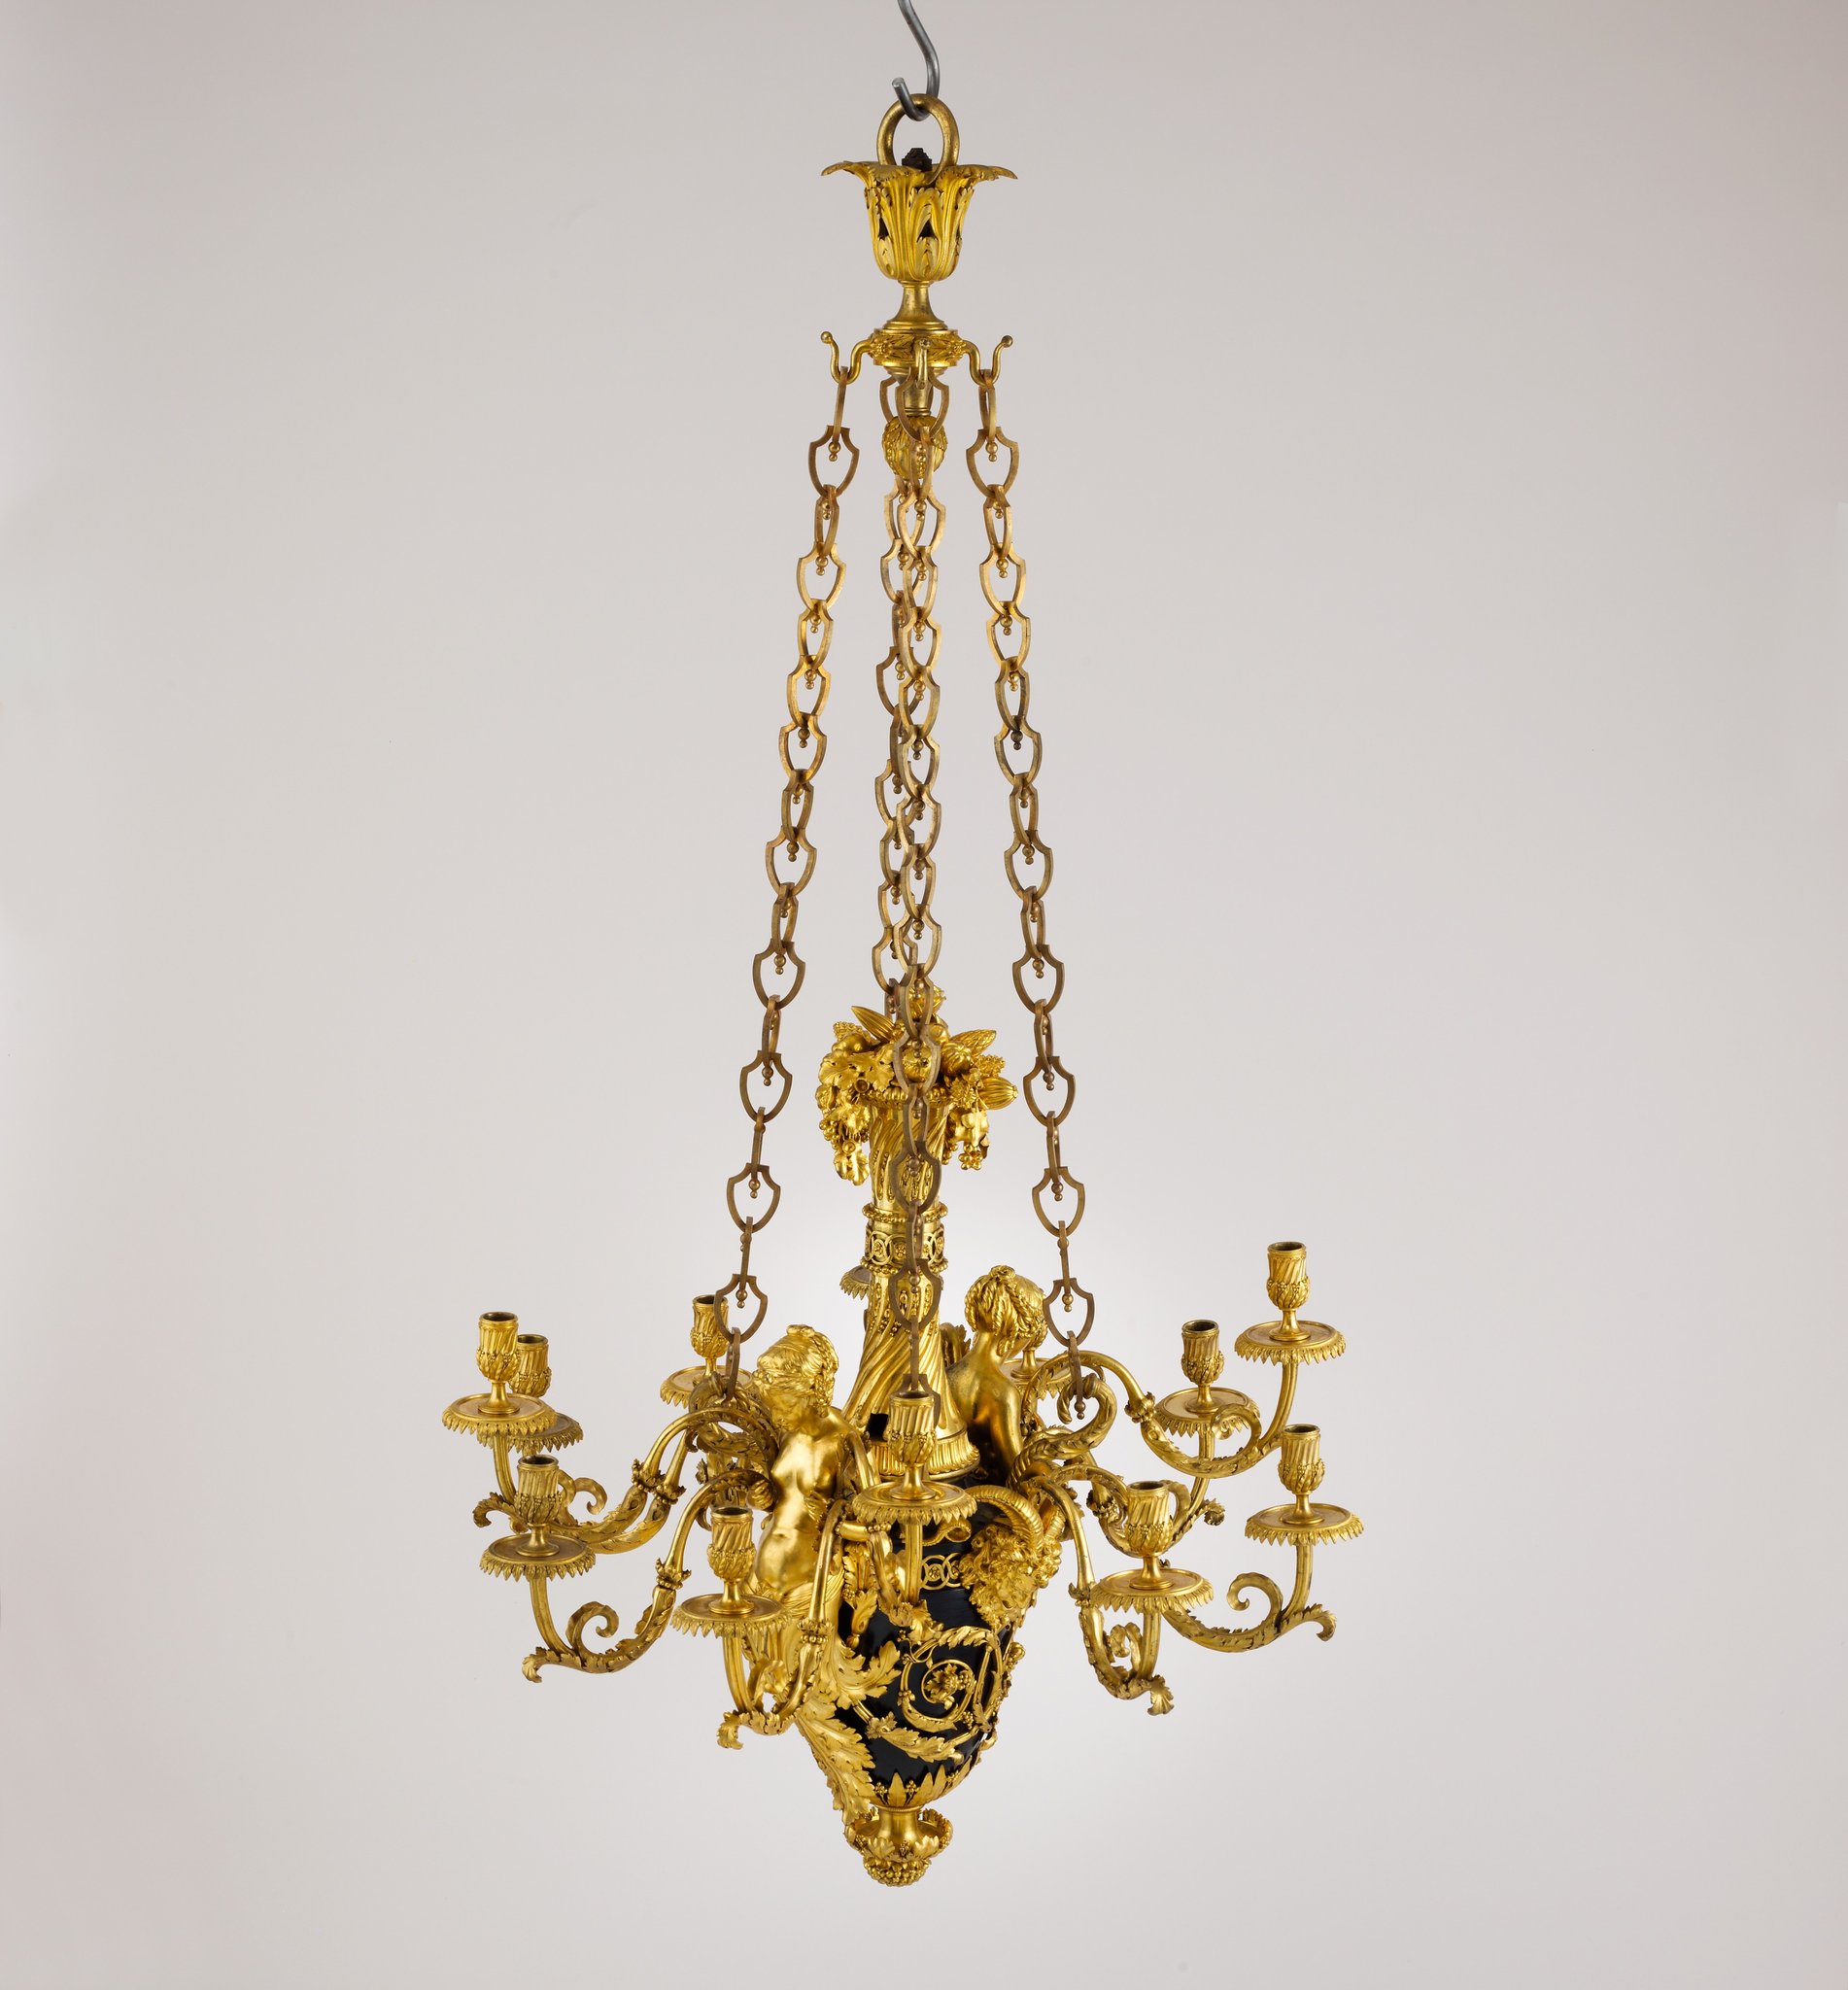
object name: chandelier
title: Twelve-light chandelier (lustre)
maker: pierre rémond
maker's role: maker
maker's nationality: french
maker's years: 1747-1812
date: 1785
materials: copper alloy, gilt bronze, varnish